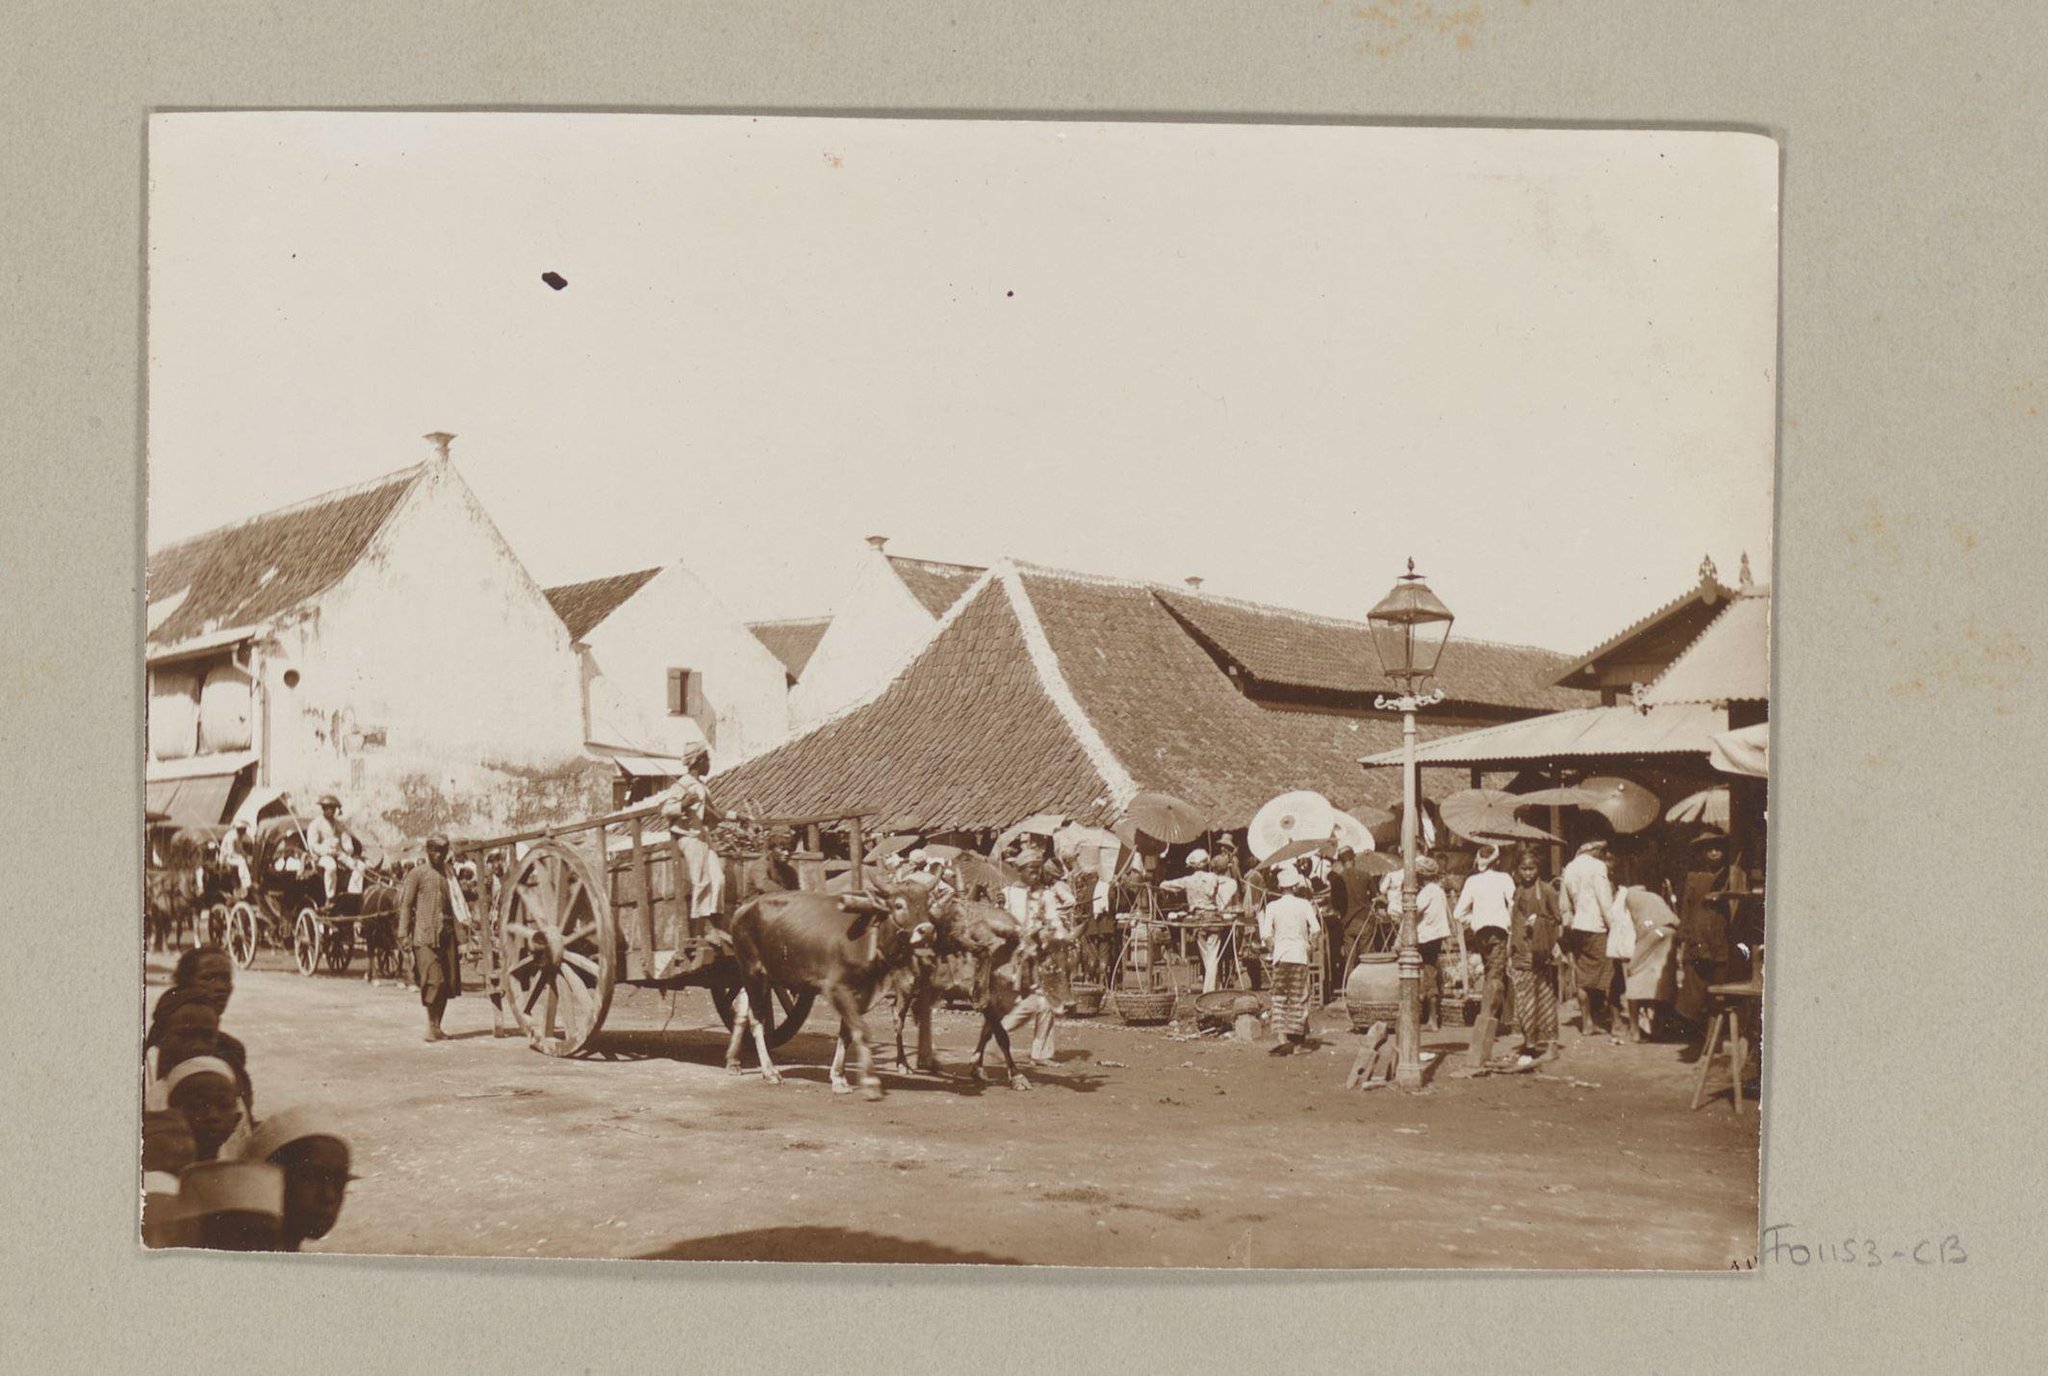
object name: photograph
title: Straatgezicht met karren en markt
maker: Anonymous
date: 1880-1900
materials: photographic support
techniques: collodion silver print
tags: animal traction, animal-drawn vehicle (carriage etc.), market, dutch east indies, the